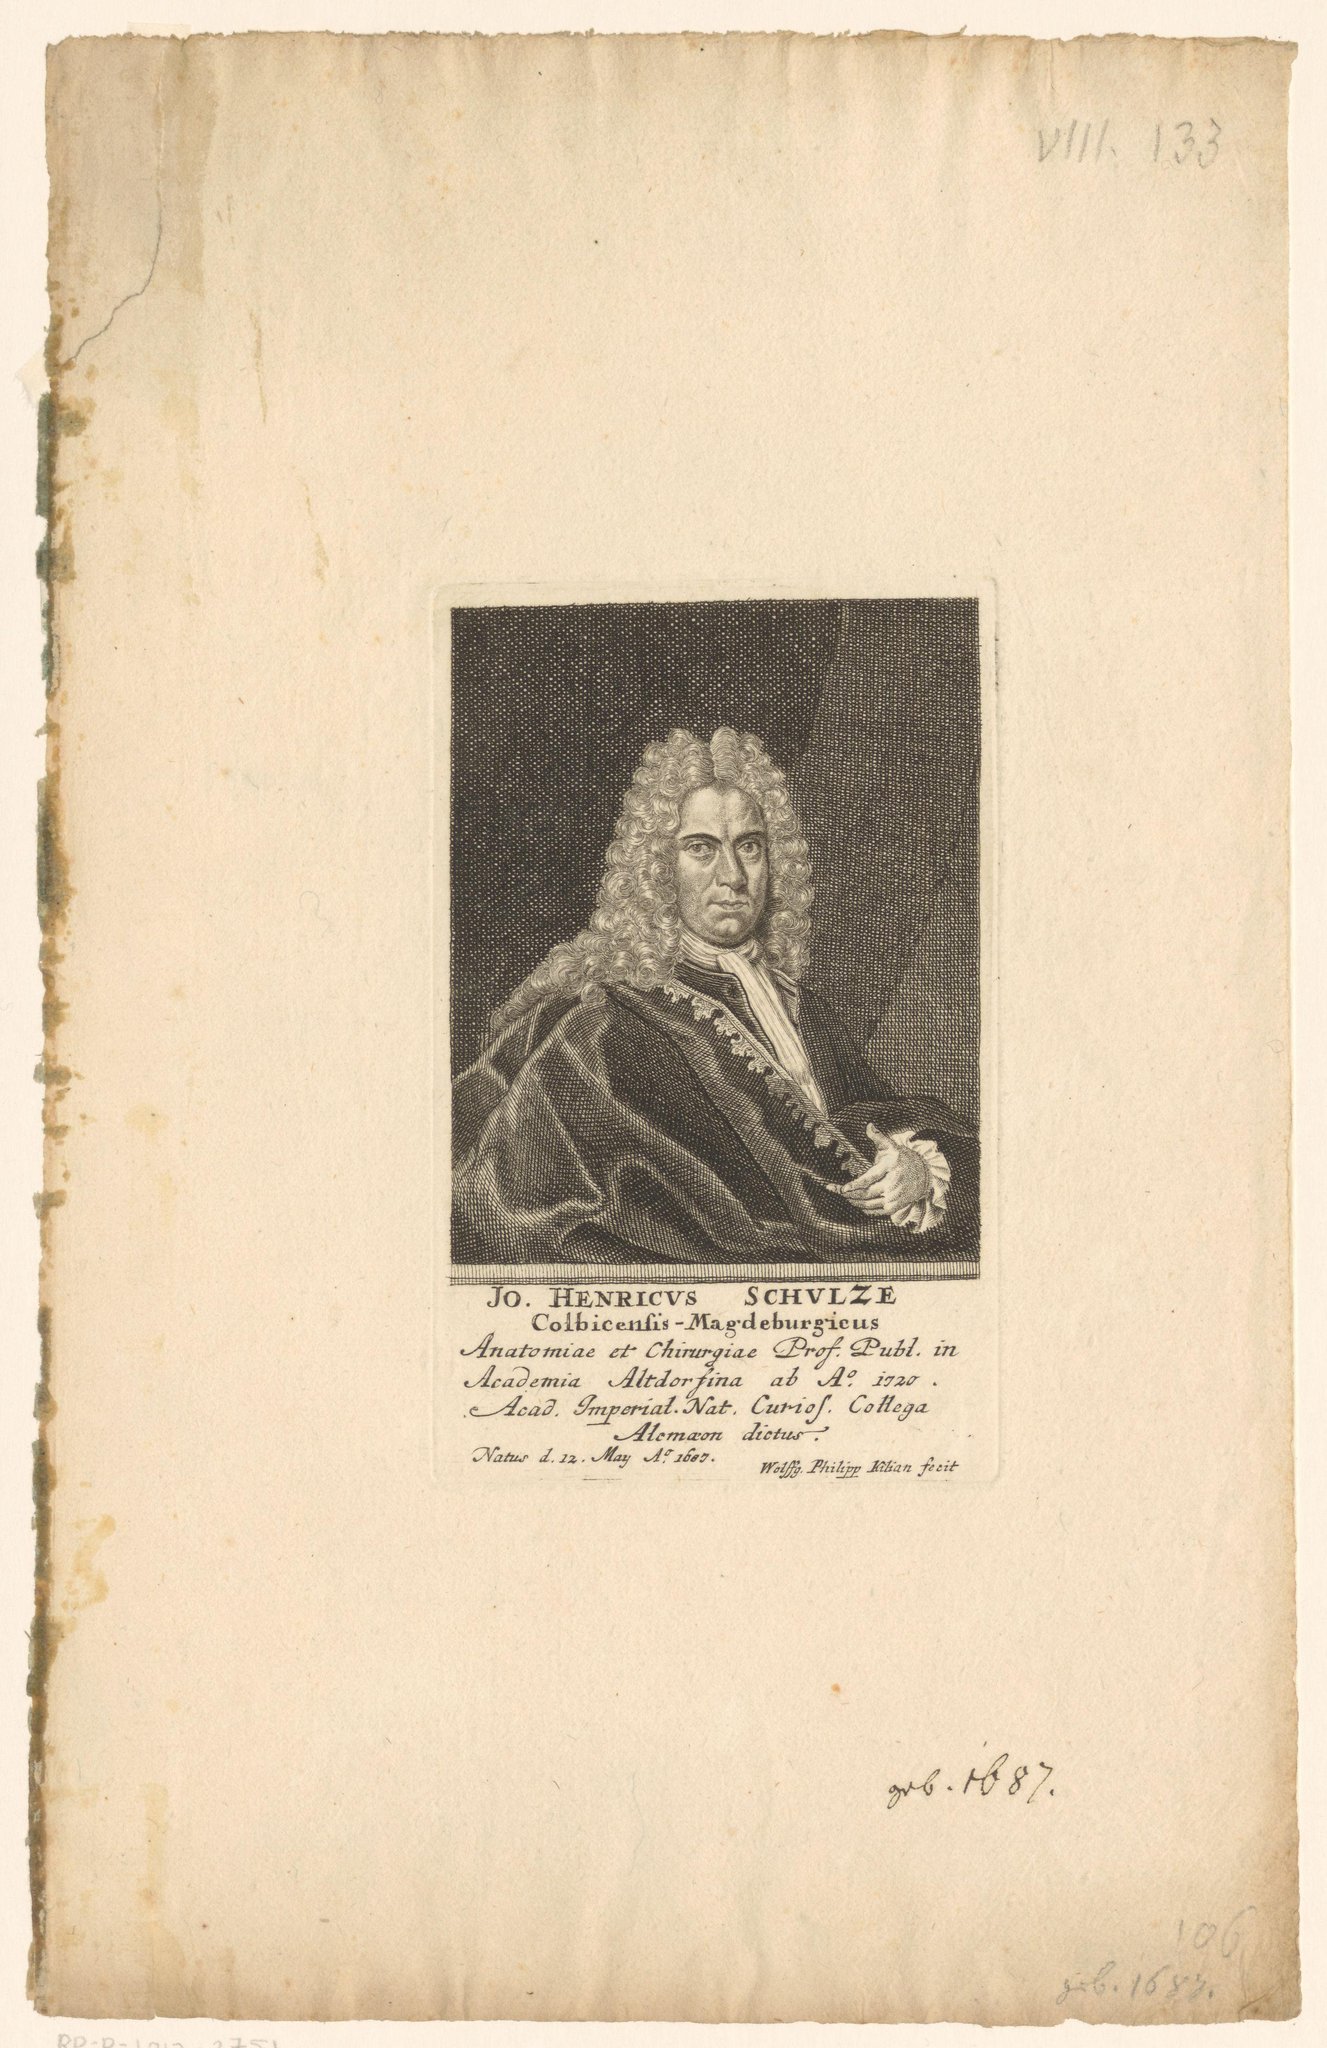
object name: print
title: Portret van Johann Heinrich Schulze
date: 1720-1728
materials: paper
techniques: engraving, etching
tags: halle, further education (+ portrait of teacher, professor), ethnology, cultural anthropology (+ portrait of scholar, scientist), historical persons, physician, doctor (+ portrait of scholar, scientist), scholar, philosopher (+ portrait of scholar, scientist)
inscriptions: collector's mark: Lugt 2228